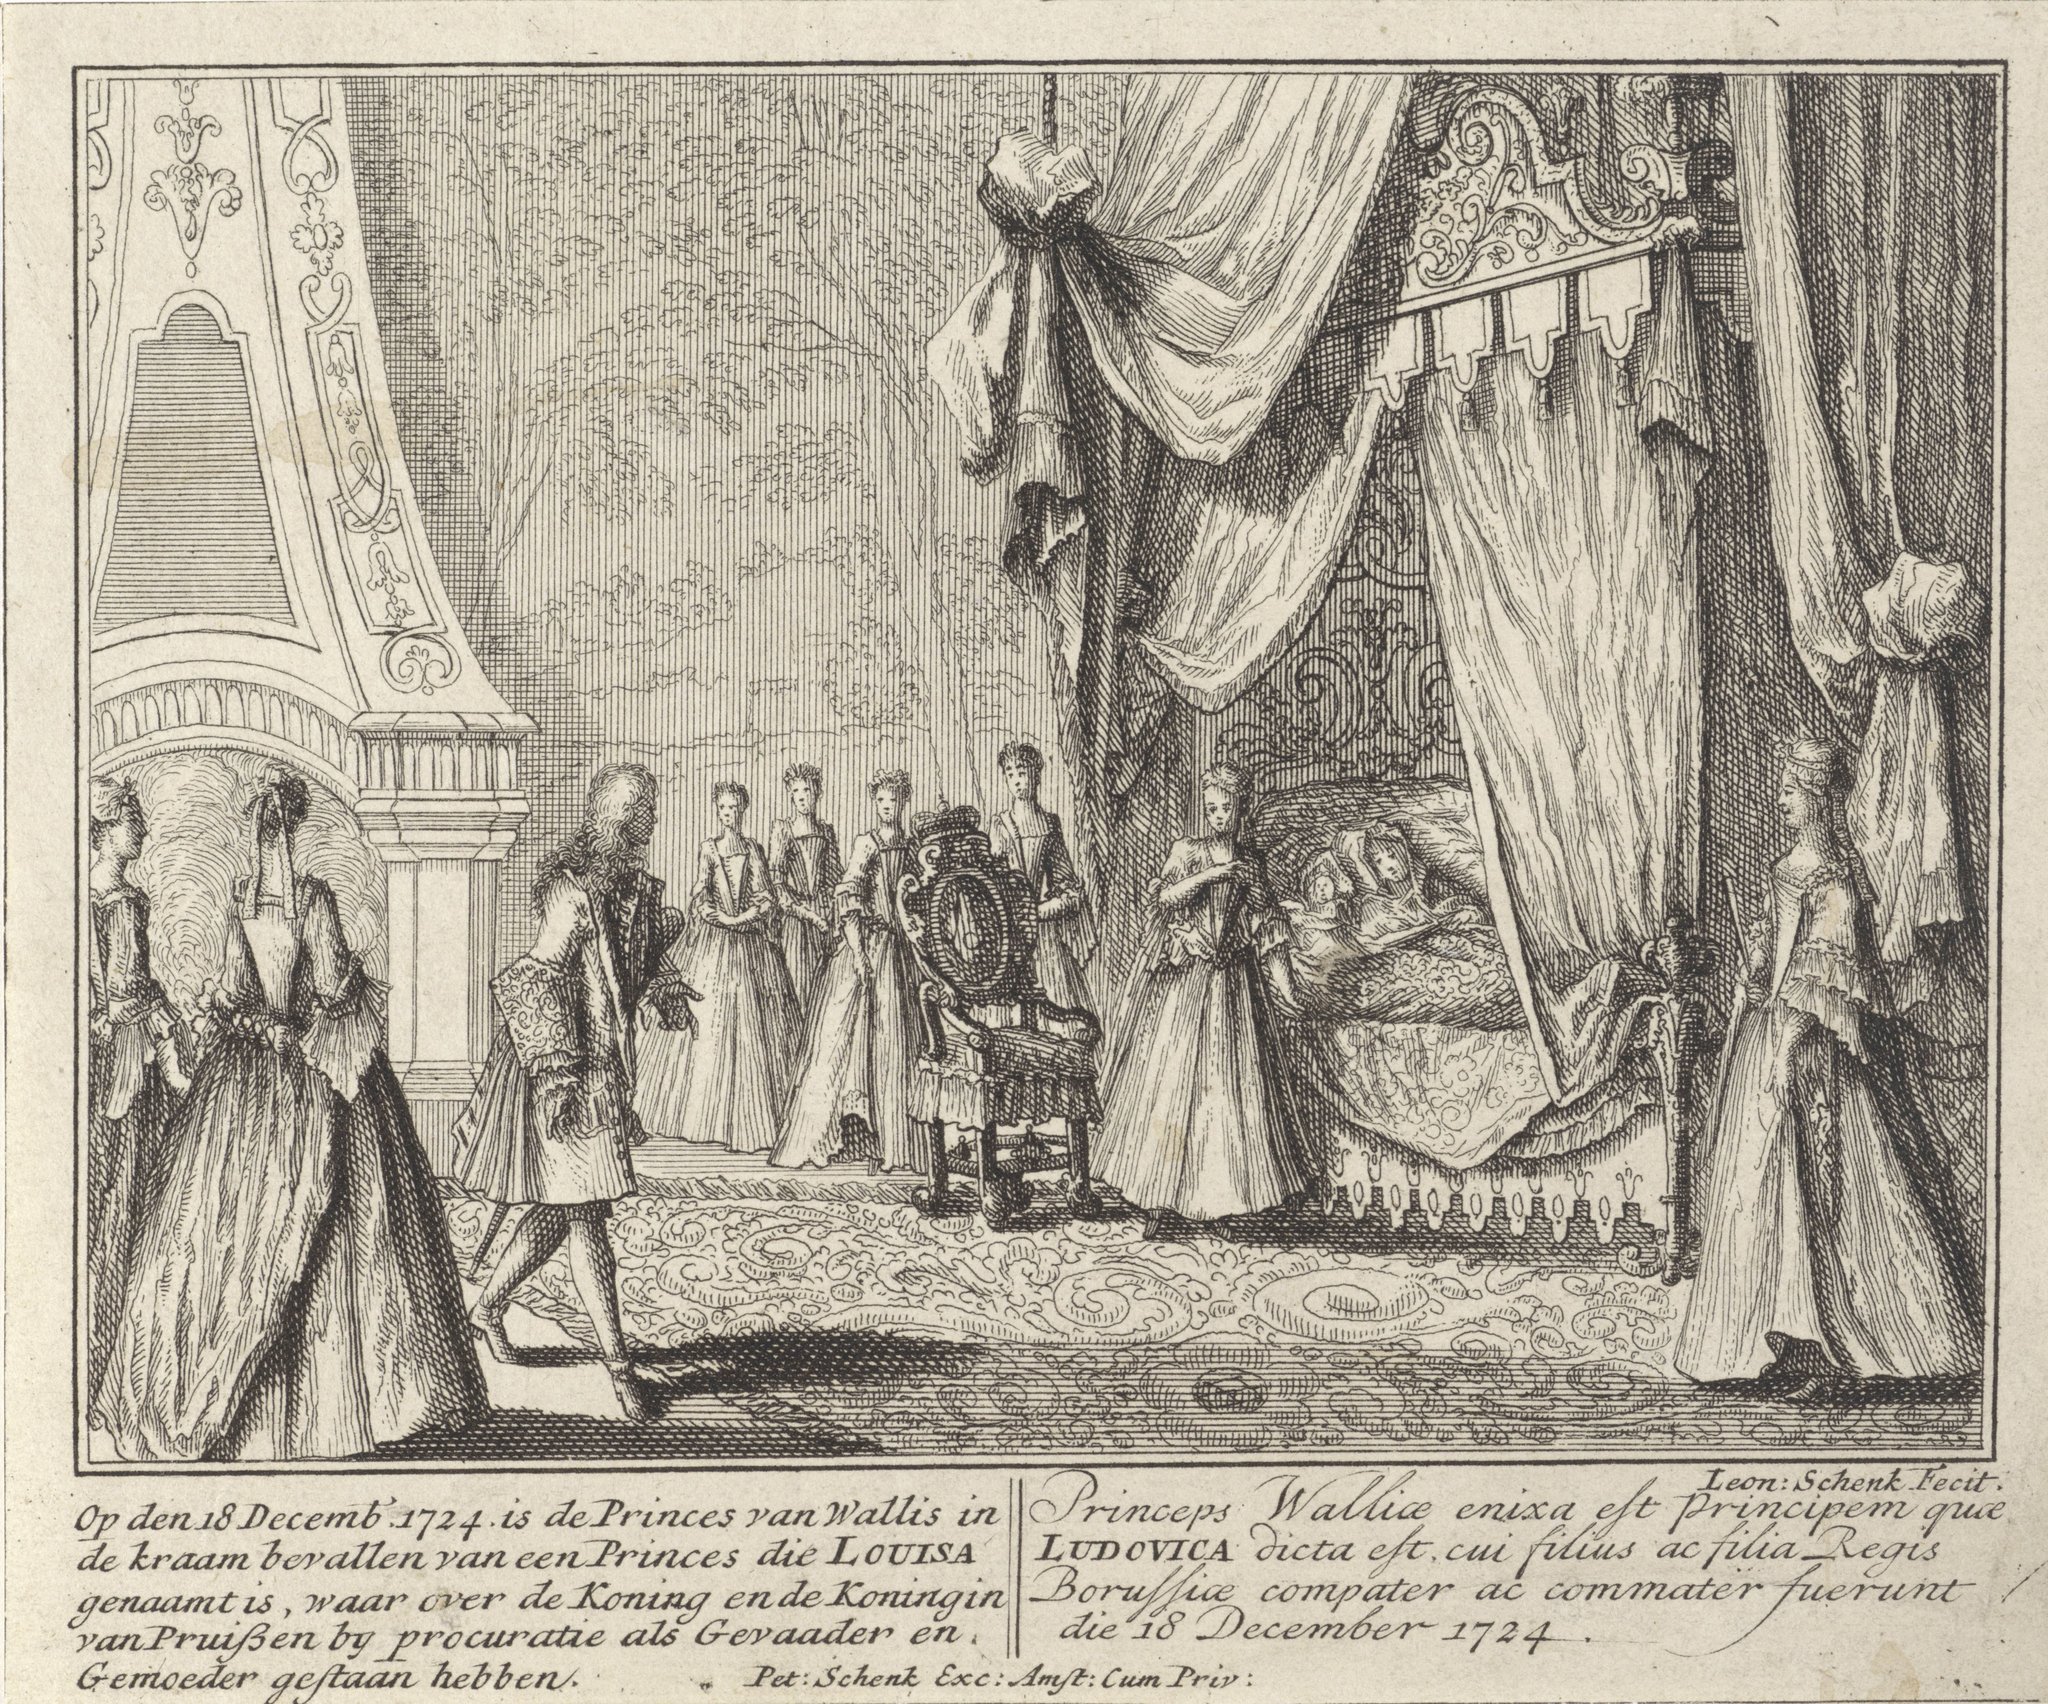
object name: book illustration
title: Caroline van Brandenburg-Ansbach in het kraambed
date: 1727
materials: paper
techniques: etching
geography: amsterdam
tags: london, george ii augustus (koning van groot-brittannië), visiting the new mother, lying-in visit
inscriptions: collector's mark: Lugt 2166, collector's mark: Lugt 2760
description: Caroline van Brandenburg-Ansbach, de latere koningin van Groot-Brittannië, ligt in het kraambed. Naast haar ligt haar pasgeboren dochter Louise van Hannover. Verschillende hofdames staan aan haar bed. Linksvoor staat haar man, de latere koning George II. Linksonder een vijfregelige tekst in het Nederlands met een toelichting op de voorstelling en rechts een vergelijkbare, vierregelige toelichting in het Latijn.